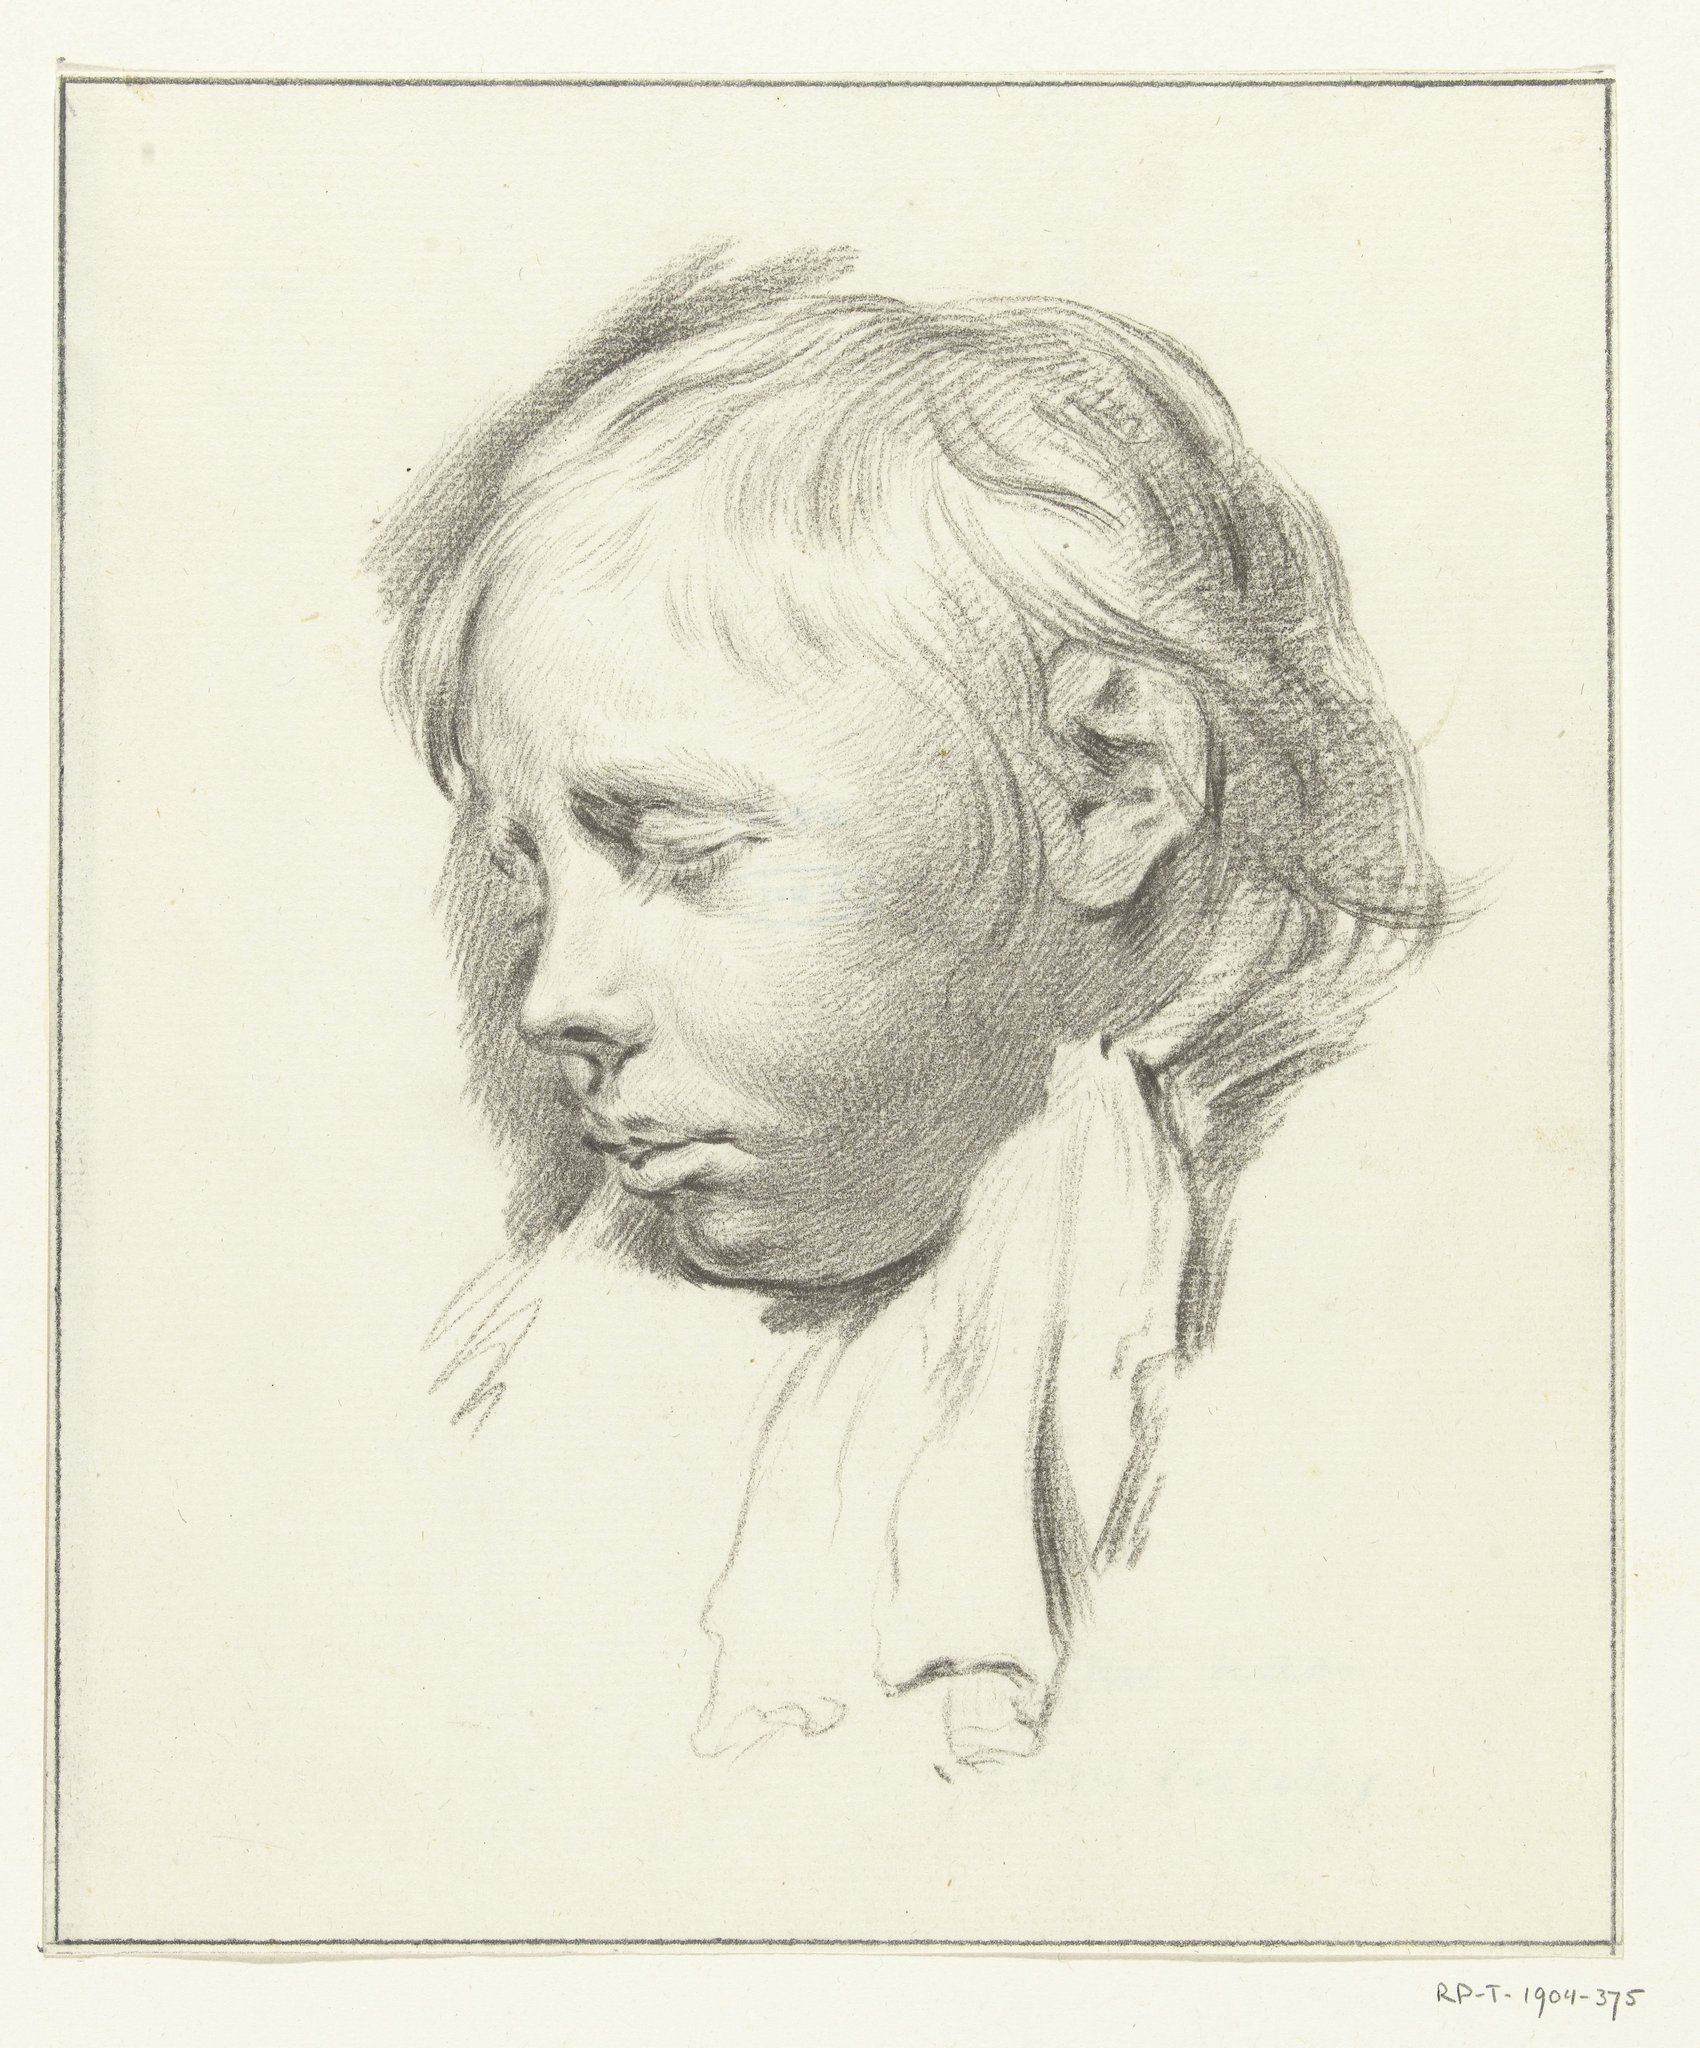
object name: drawing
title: Hoofd van slapende jongen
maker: jean bernard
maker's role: draughtsman, print maker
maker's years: 1765-1833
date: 1775-1833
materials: chalk, paper, pencil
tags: sleeping; unconsciousness